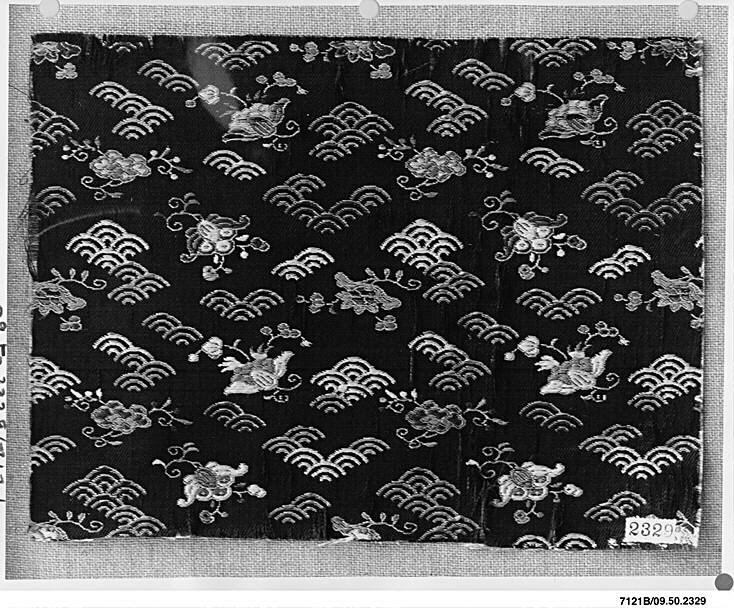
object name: piece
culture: japanese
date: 1615-1868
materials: silk